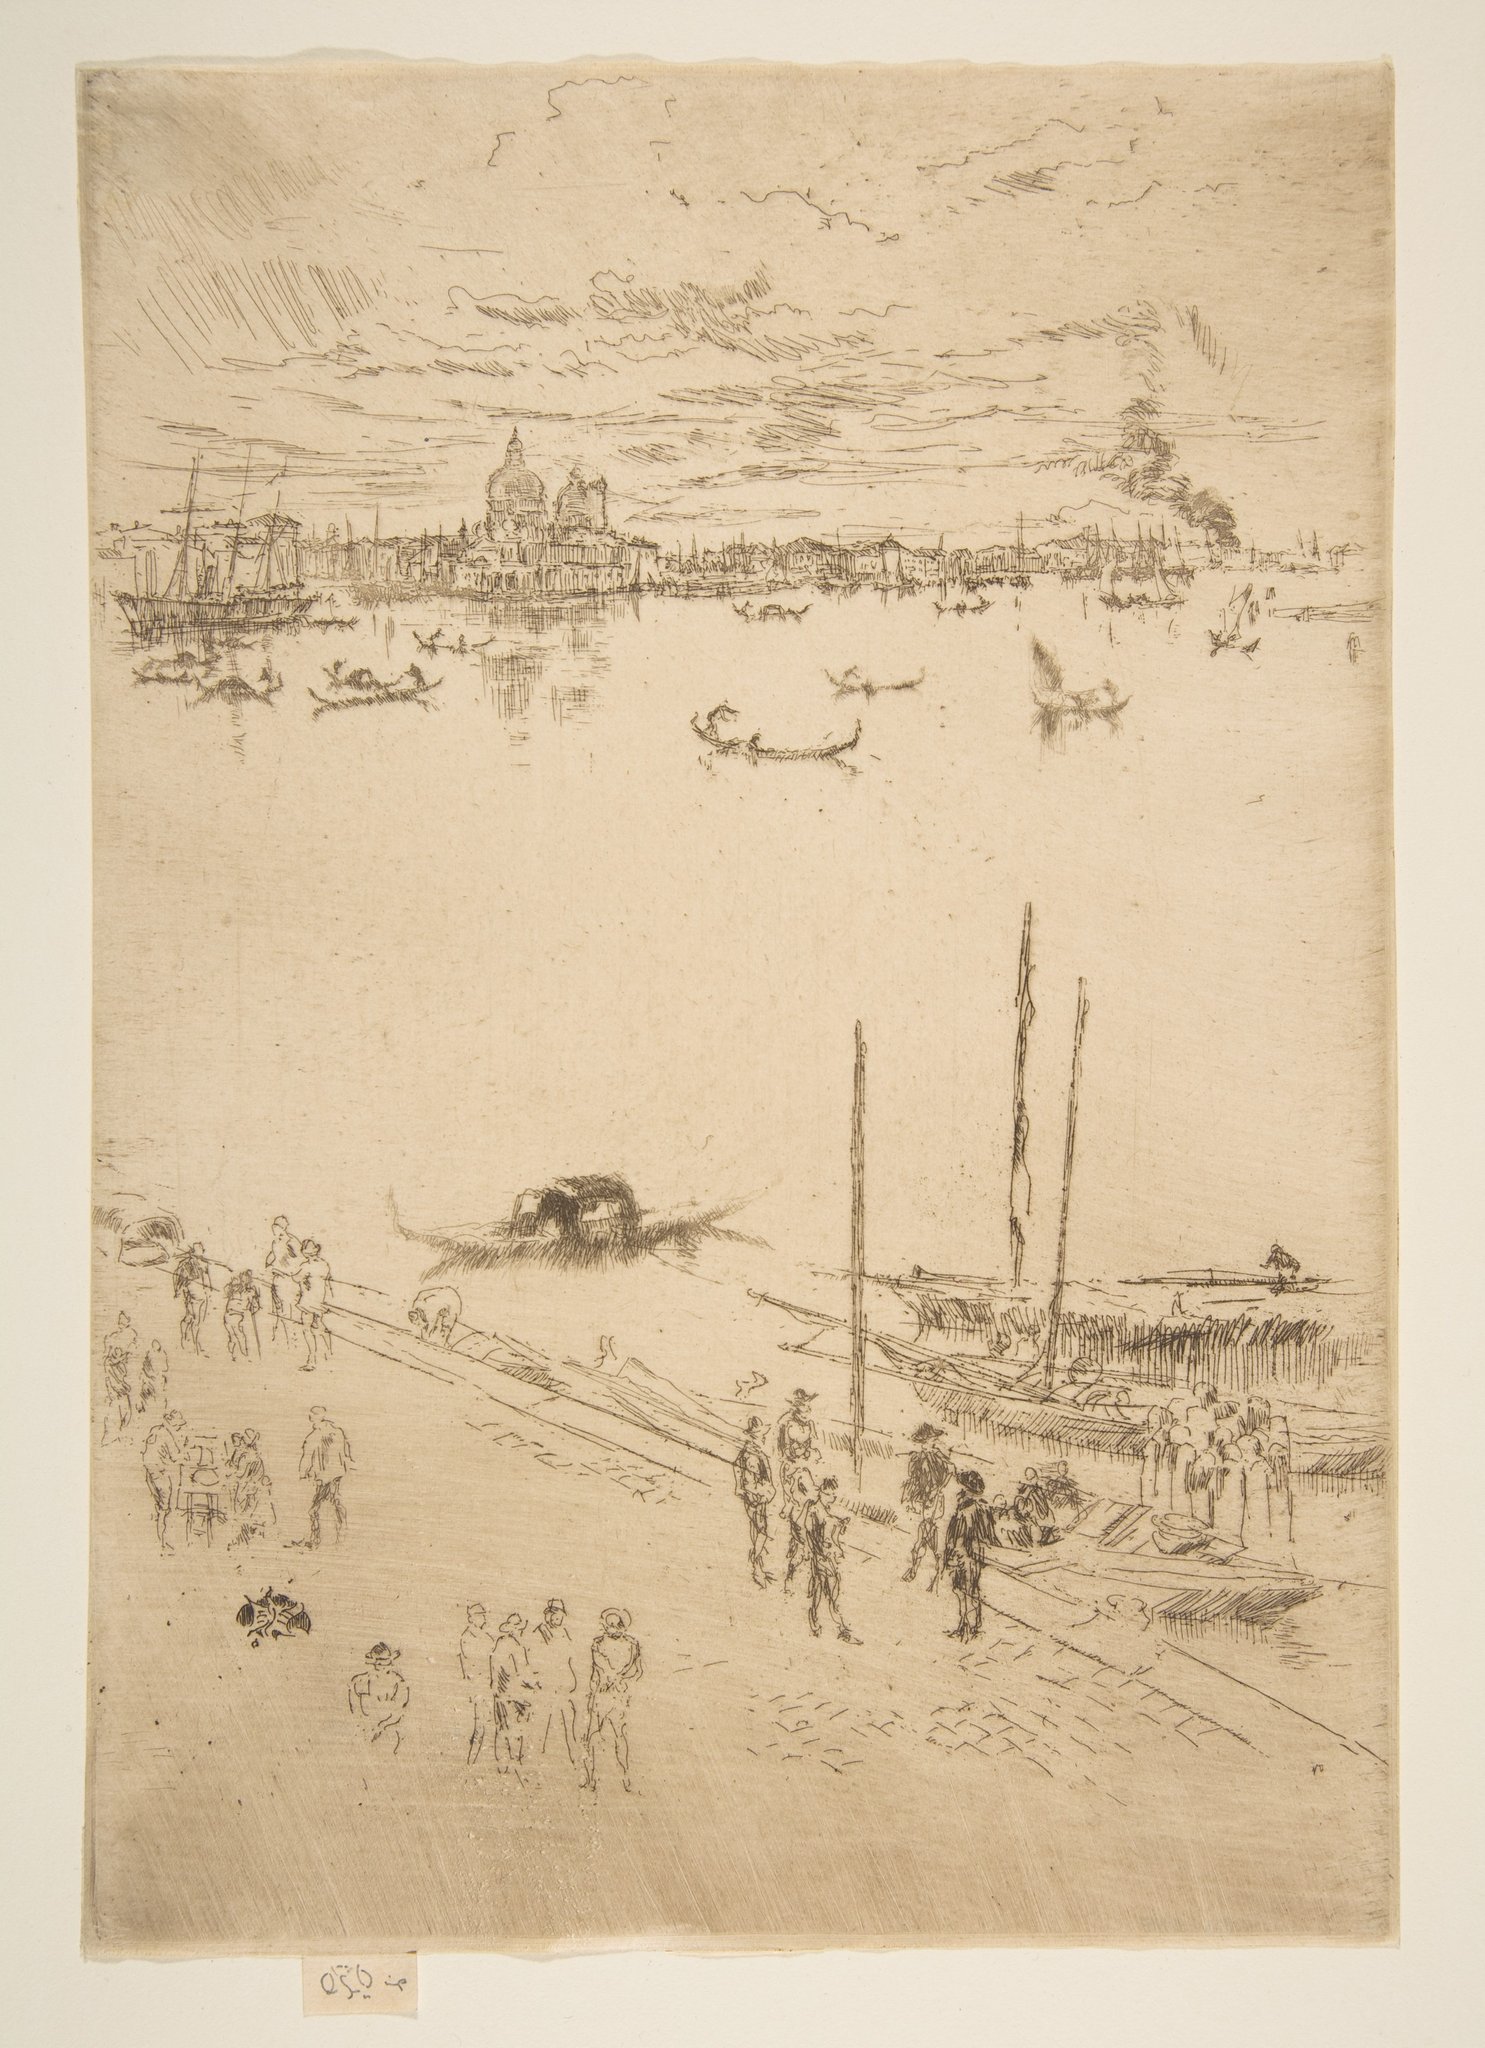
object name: print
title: Upright Venice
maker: james mcneill whistler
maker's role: artist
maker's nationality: american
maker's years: 1834-1903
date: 1879-1880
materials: ink, paper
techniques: drypoint, etching, printing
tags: canals,boats,venice